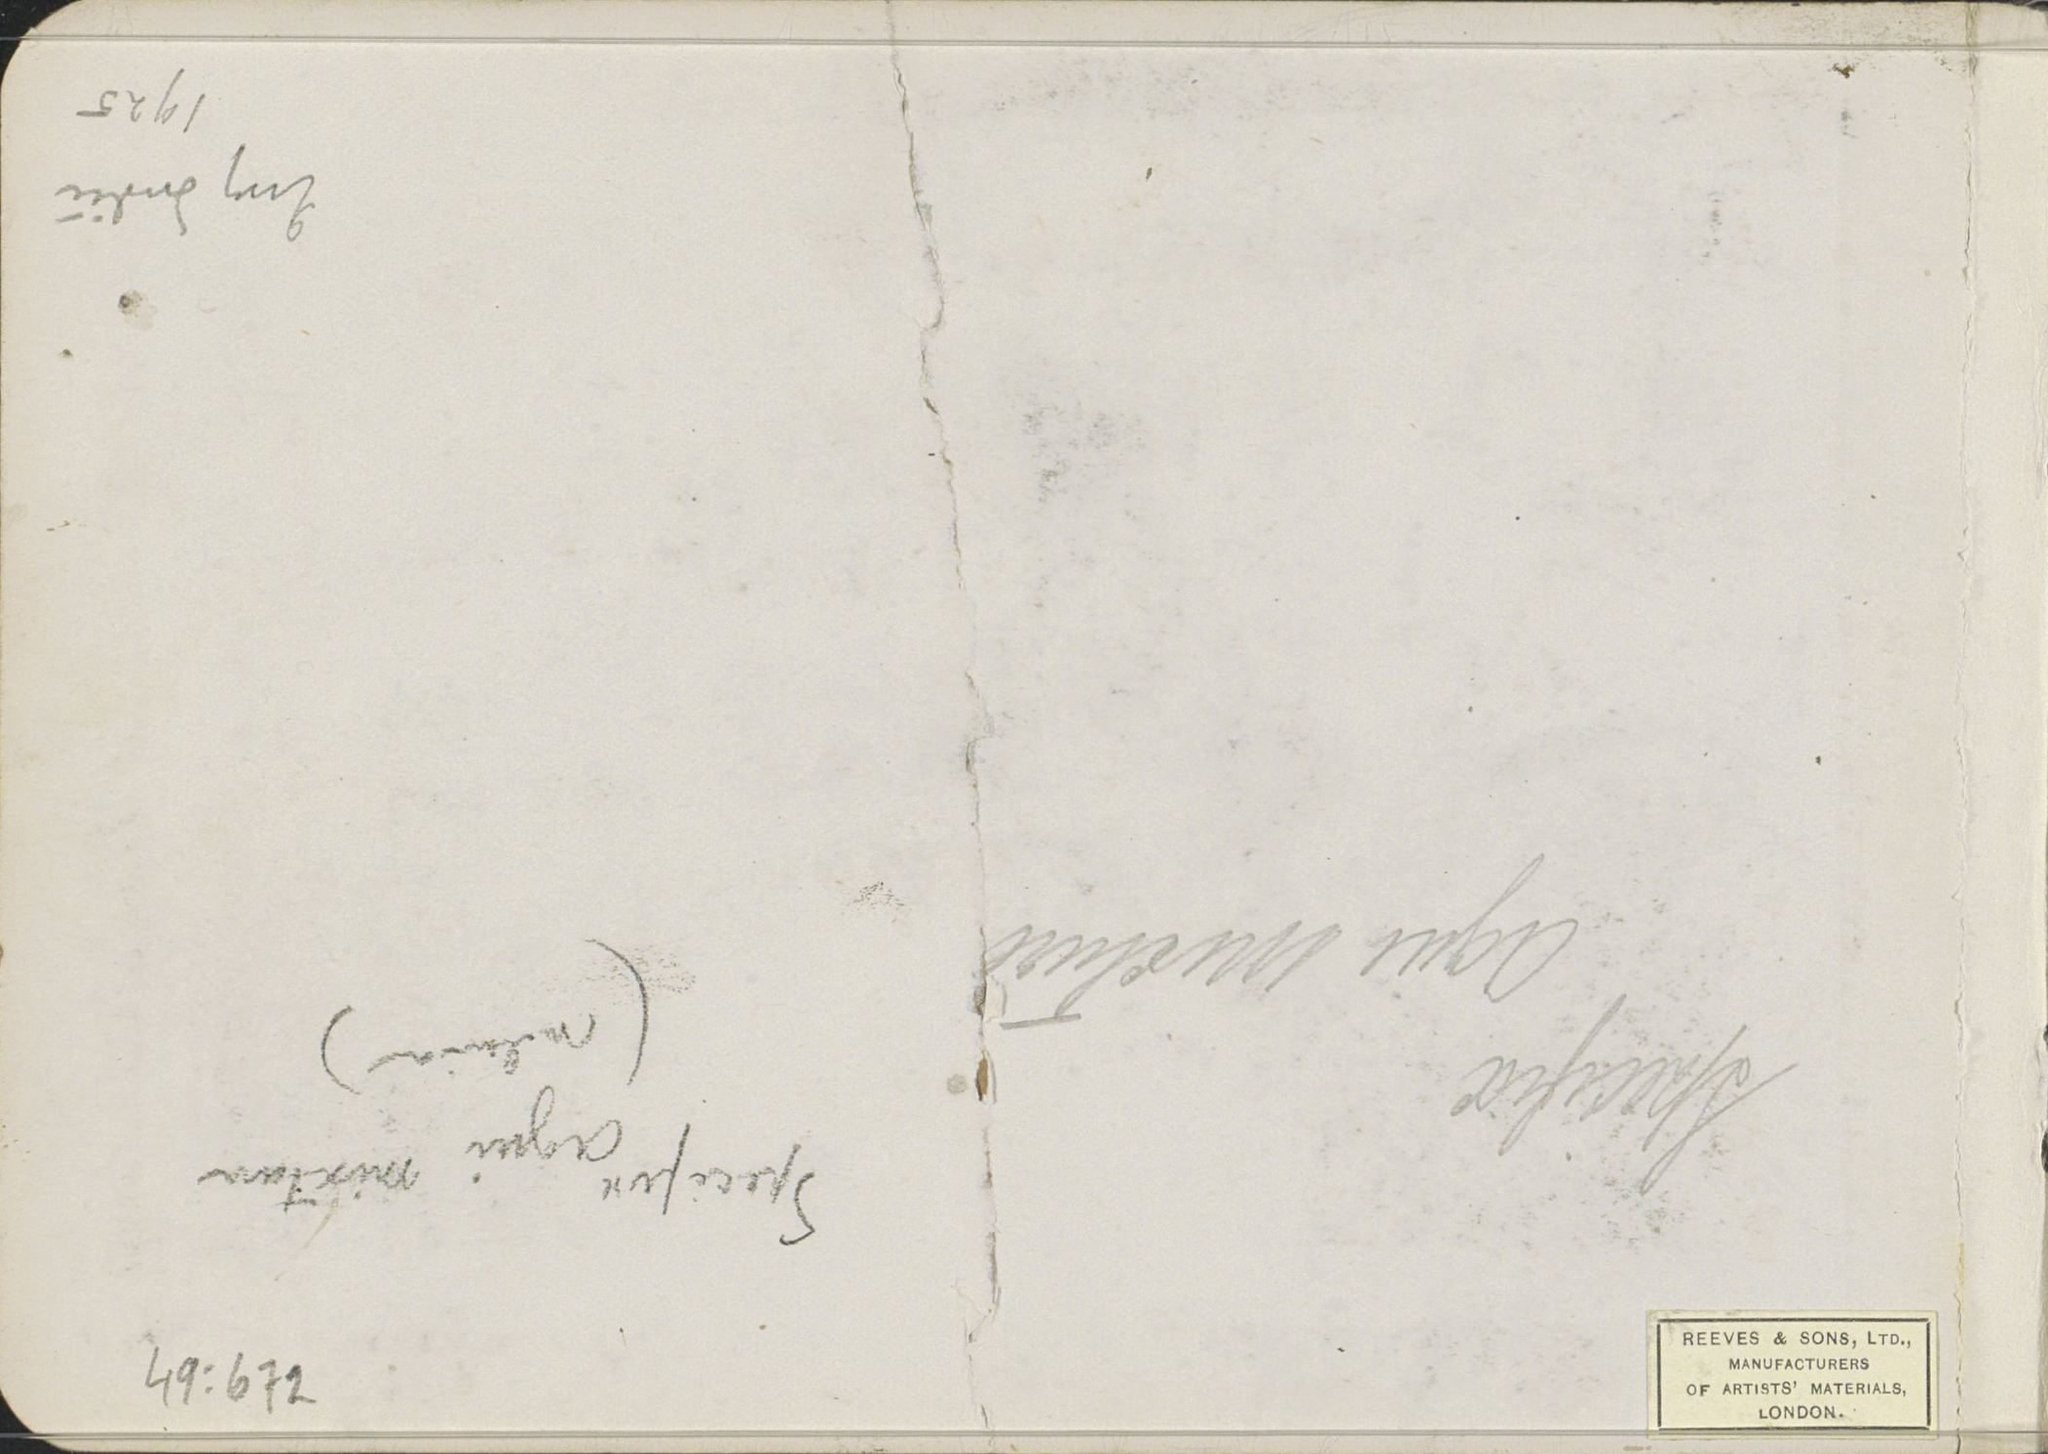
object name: endleaf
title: Notities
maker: marius bauer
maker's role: draughtsman, print maker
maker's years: 1867-1932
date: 1925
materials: chalk, paper, pencil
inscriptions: retailer's mark: ‘REEVES & SONS LTD.,/ MANUFACTURERS/ OF ARTISTS' MATERIALS,/ LONDON.’, annotation: ‘Specifix/ Agui Mixt[...]/ Specifix/ Agui Mixt[...]/ (malaria)/ [...]/ 1925’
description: Voorste schutblad uit een schetsboek met 15 bladen.